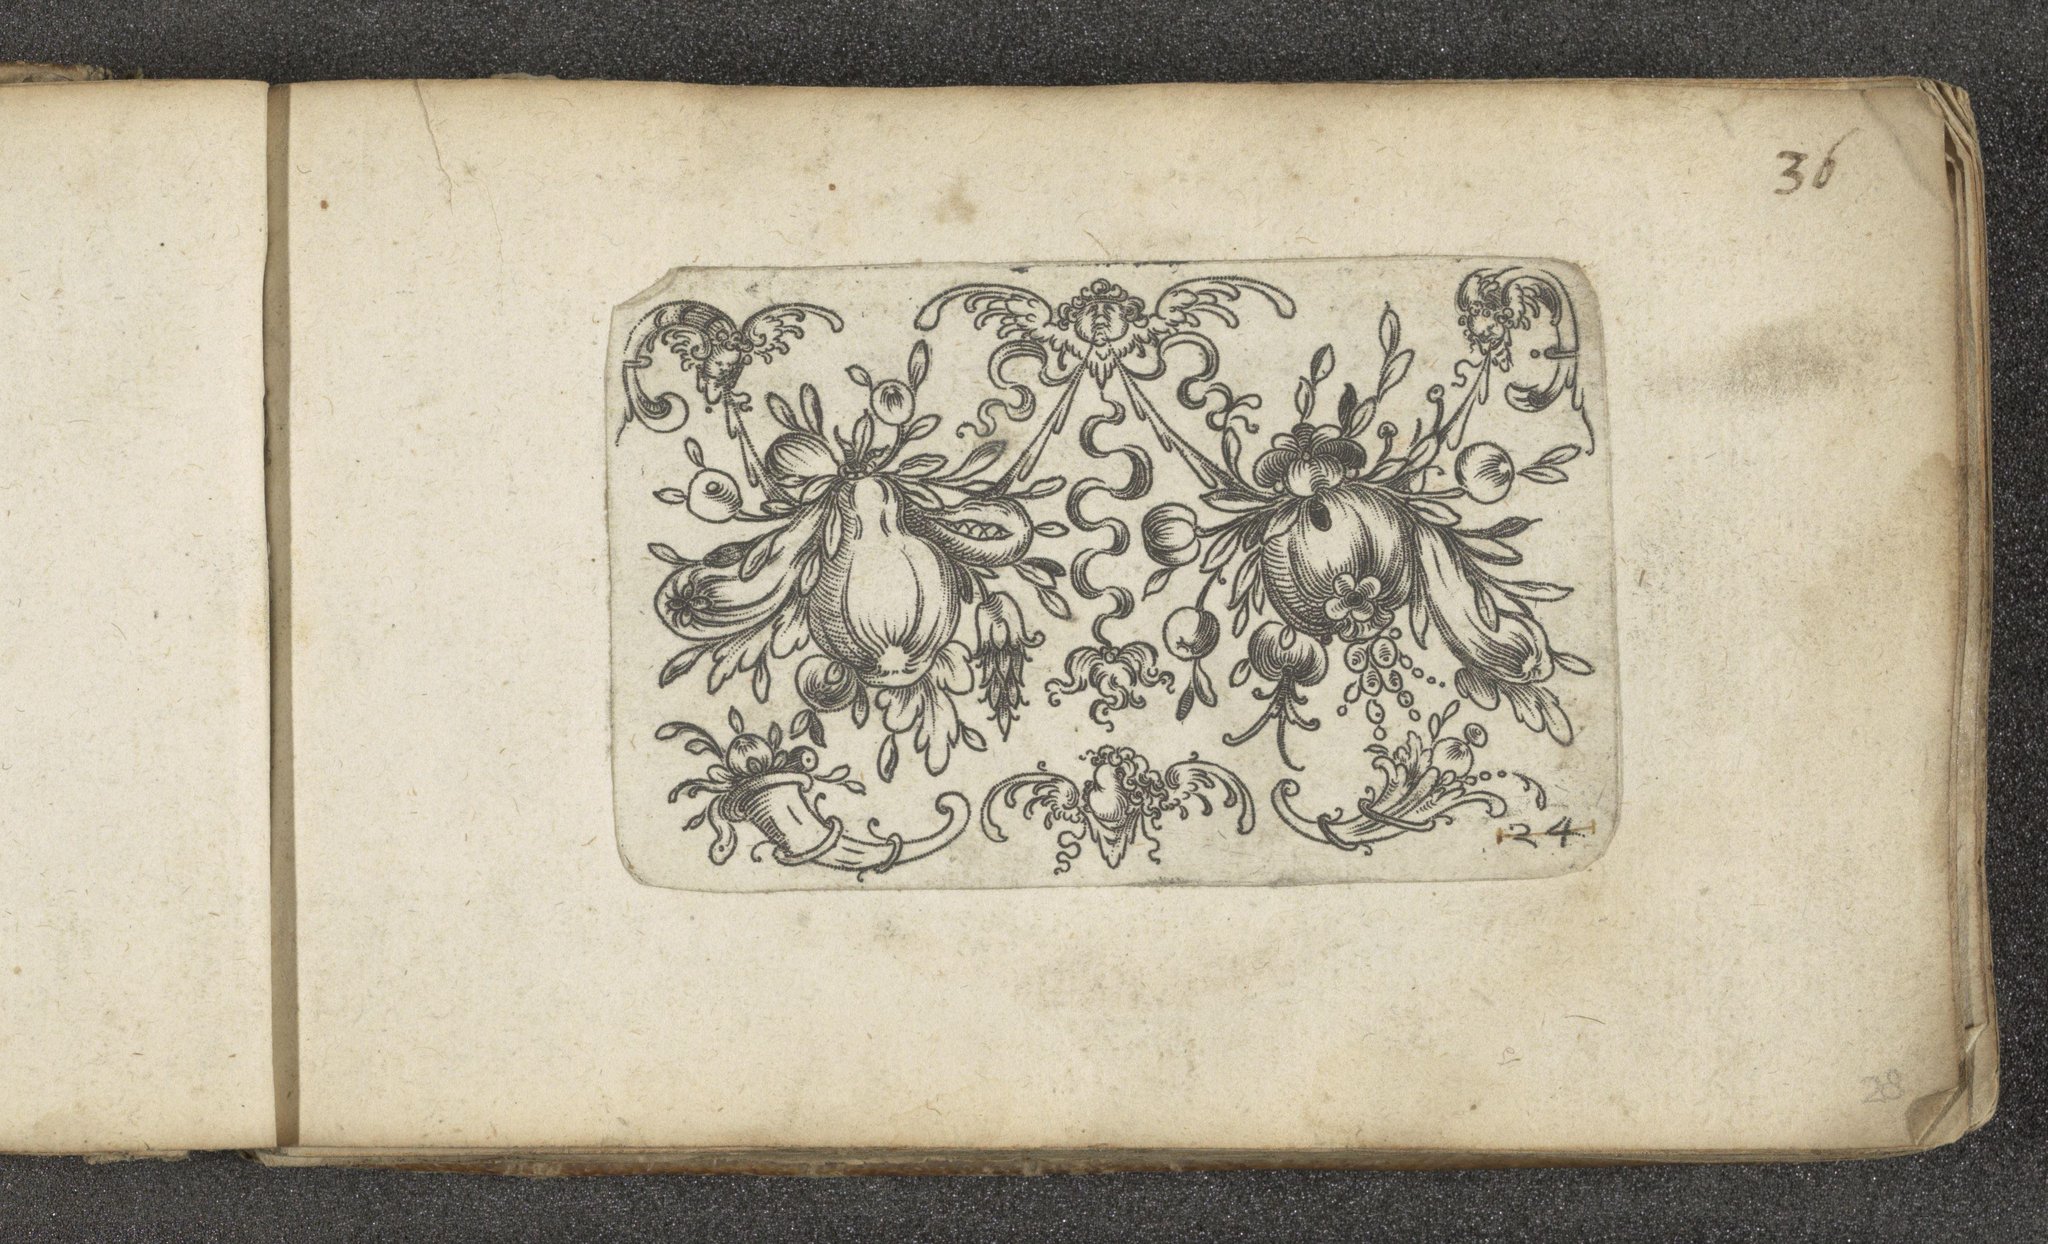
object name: album leaf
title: Twee trossen fruit, twee cornucopia en een cherubijn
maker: Anonymous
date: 1601-1650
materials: paper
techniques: etching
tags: cherubs, i.e. children's heads with wings, 'cornucopia', horn of plenty, ornaments ~ art, fruits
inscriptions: inscription: ‘36’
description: Guirlande met twee trossen fruit. Daaronder twee cornucopia en een cherubijn. Rechtsonder genummerd: 24. De prent maakt deel uit van een album.